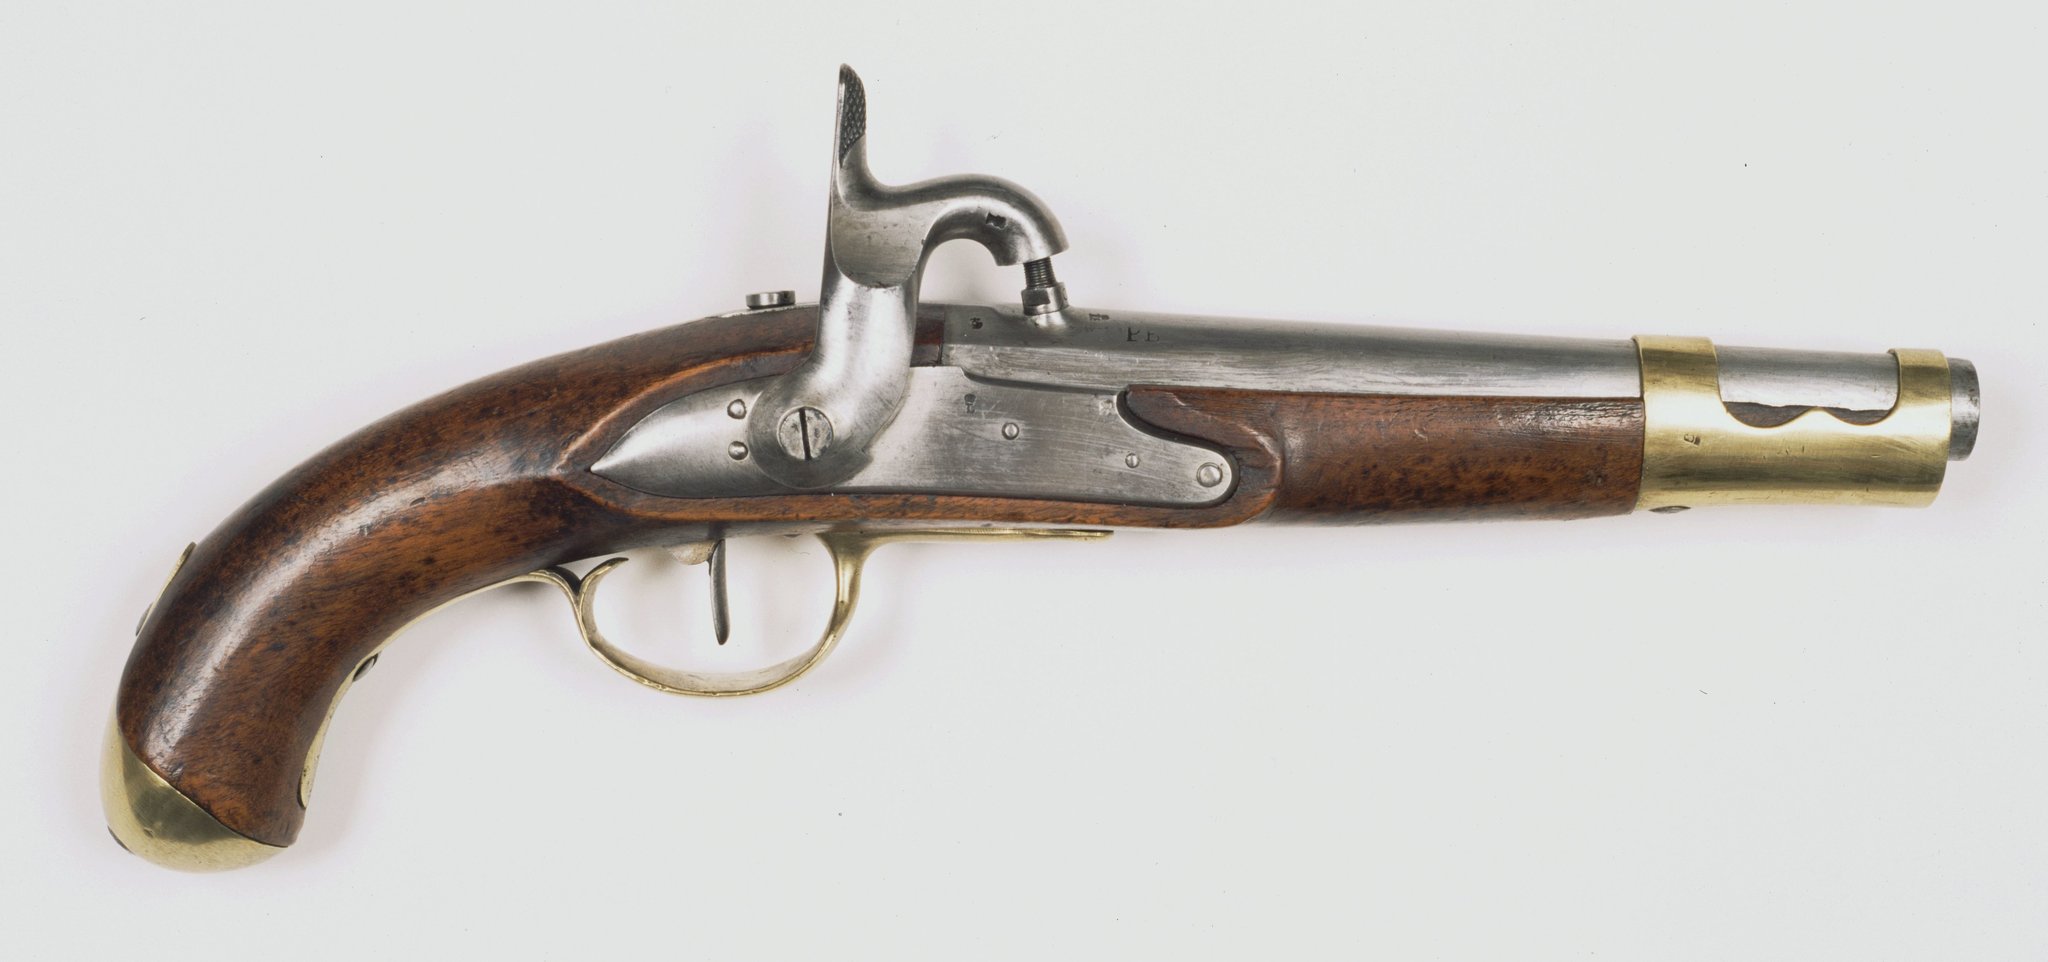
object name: percussion pistol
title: Percussie legerpistool model M 1815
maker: Anonymous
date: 1815-1816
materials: brass, iron, wood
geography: netherlands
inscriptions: signature: ‘L met kroon’, signature: ‘kroon’, signature: ‘IS met kroon K met kroon’, mark: ‘1816’, signature: ‘IB met kroon’, signature: ‘PB’